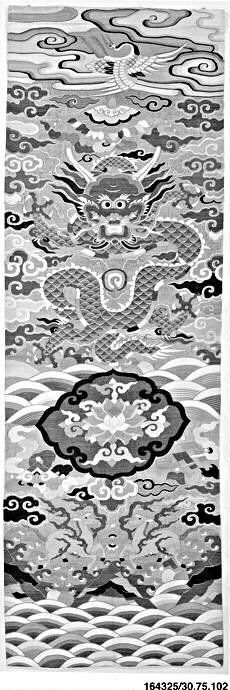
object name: chair strip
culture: chinese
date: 1601-1700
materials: metal thread, silk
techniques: tapestry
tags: cranes,dragons